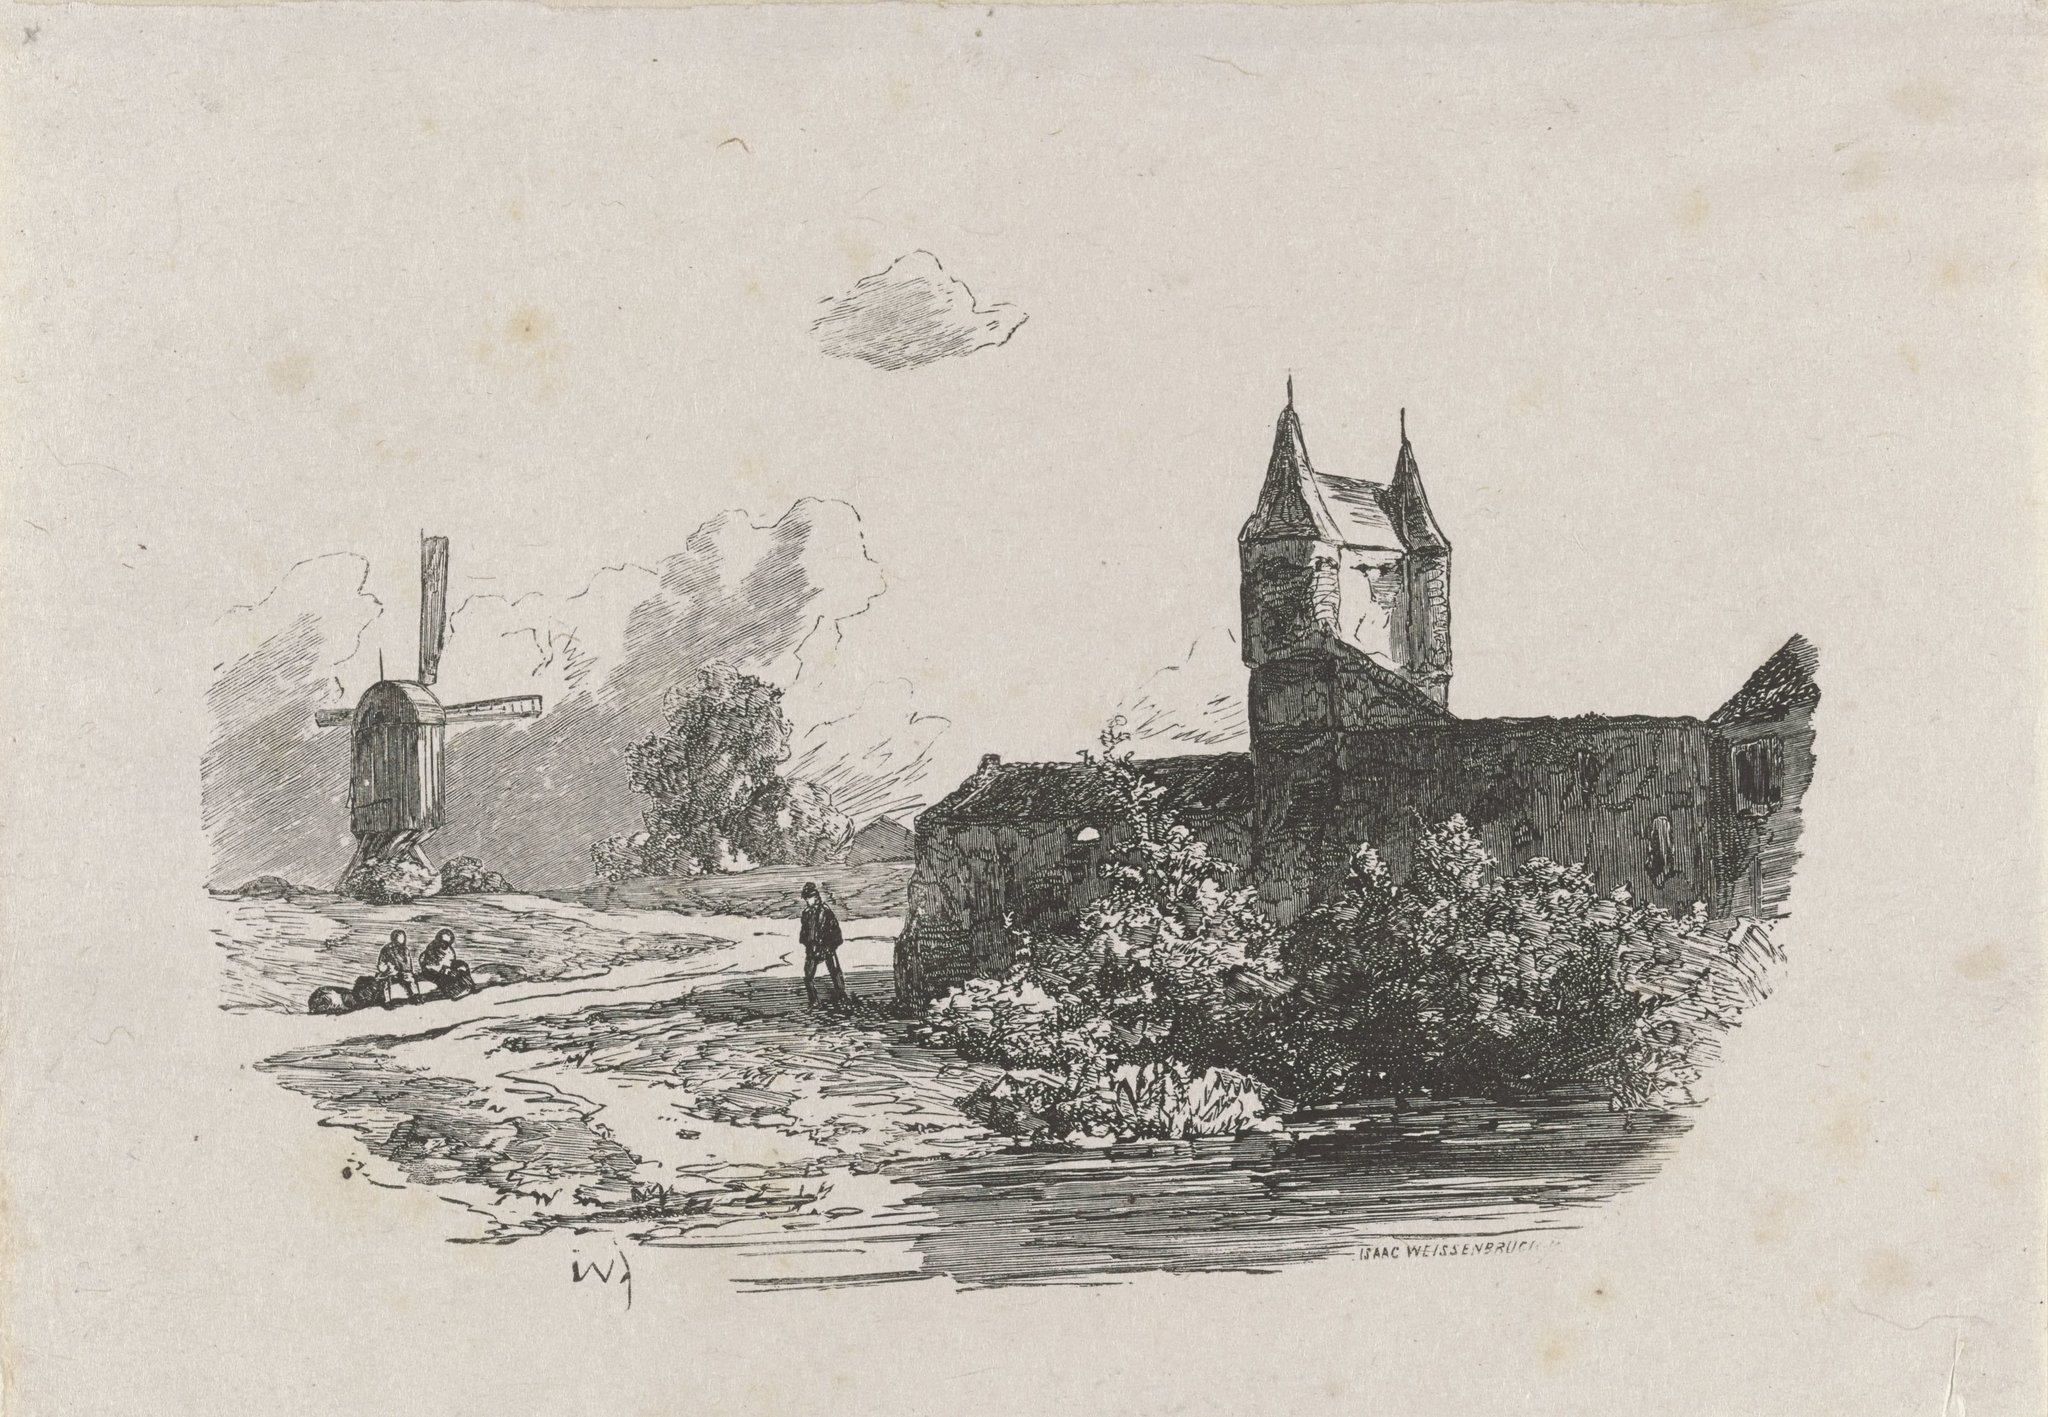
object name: print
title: Waterpoort aan de rand van een stad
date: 1836-1912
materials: paper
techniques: engraving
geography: netherlands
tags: city-view, and landscape with man-made constructions, watergate, windmill in landscape (+ city(-scape) with figures, staffage)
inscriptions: collector's mark: Lugt 2228